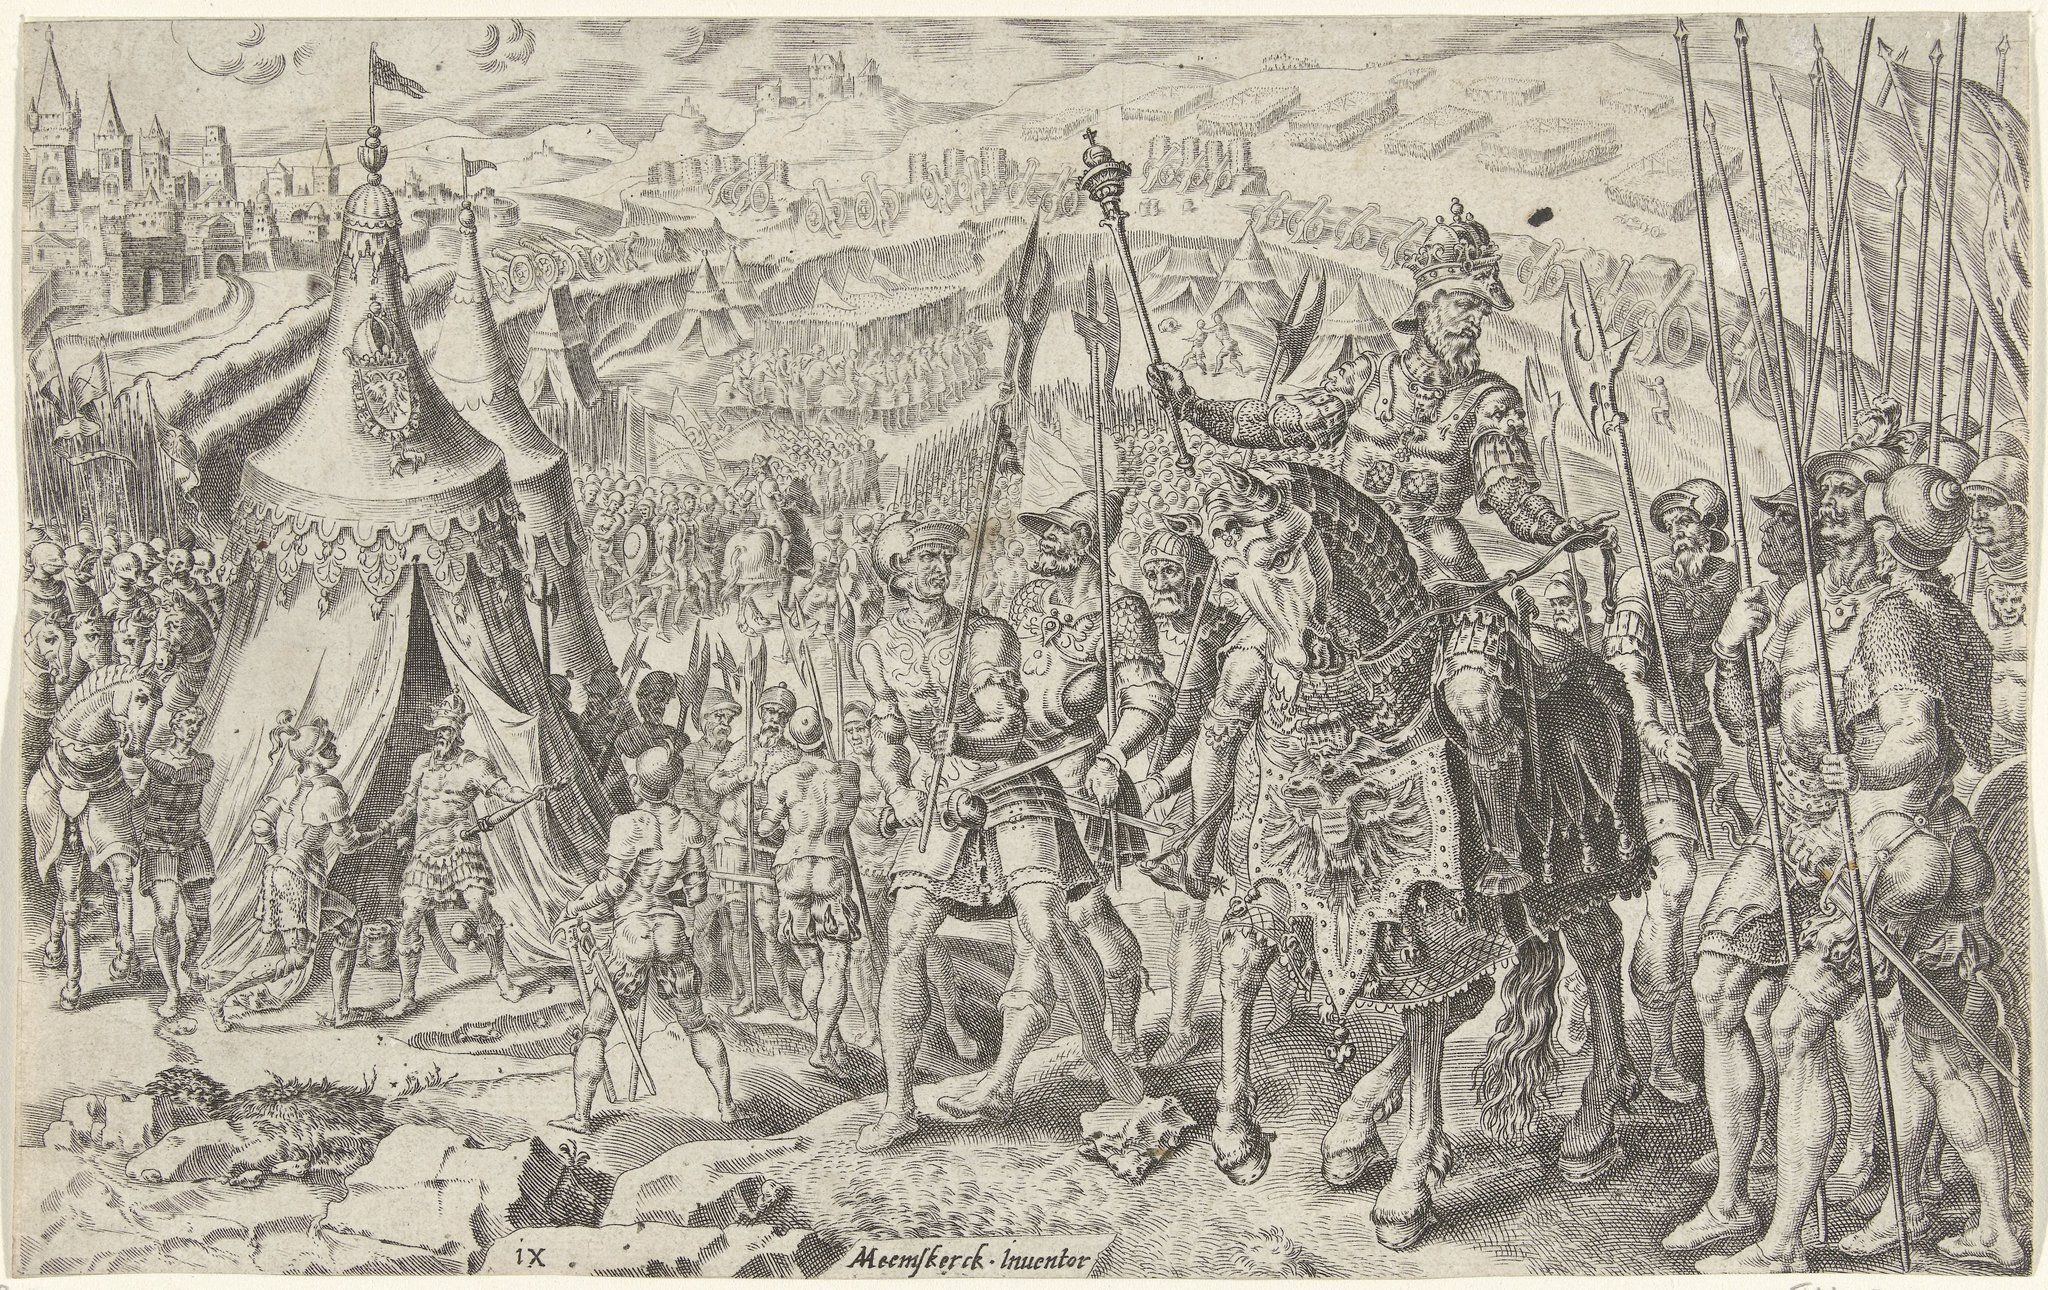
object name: history print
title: Divi Caroli. V. imp. opt. max. victoriae, ex multis praecipuae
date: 1555-1556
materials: paper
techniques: engraving, etching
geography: haarlem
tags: brussels, ghent, charles v (holy roman emperor and king of spain)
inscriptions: collector's mark: Lugt 2228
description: Keizer Karel V inspecteert zijn troepen te Ingolstadt (1546) en spreekt hen moed in. In de achtergrond komt de graaf van Buren samen met zijn leger aan bij de tent van Karel V. De prent maakt deel uit van een twaalfdelige serie over de overwinningen van Karel V.